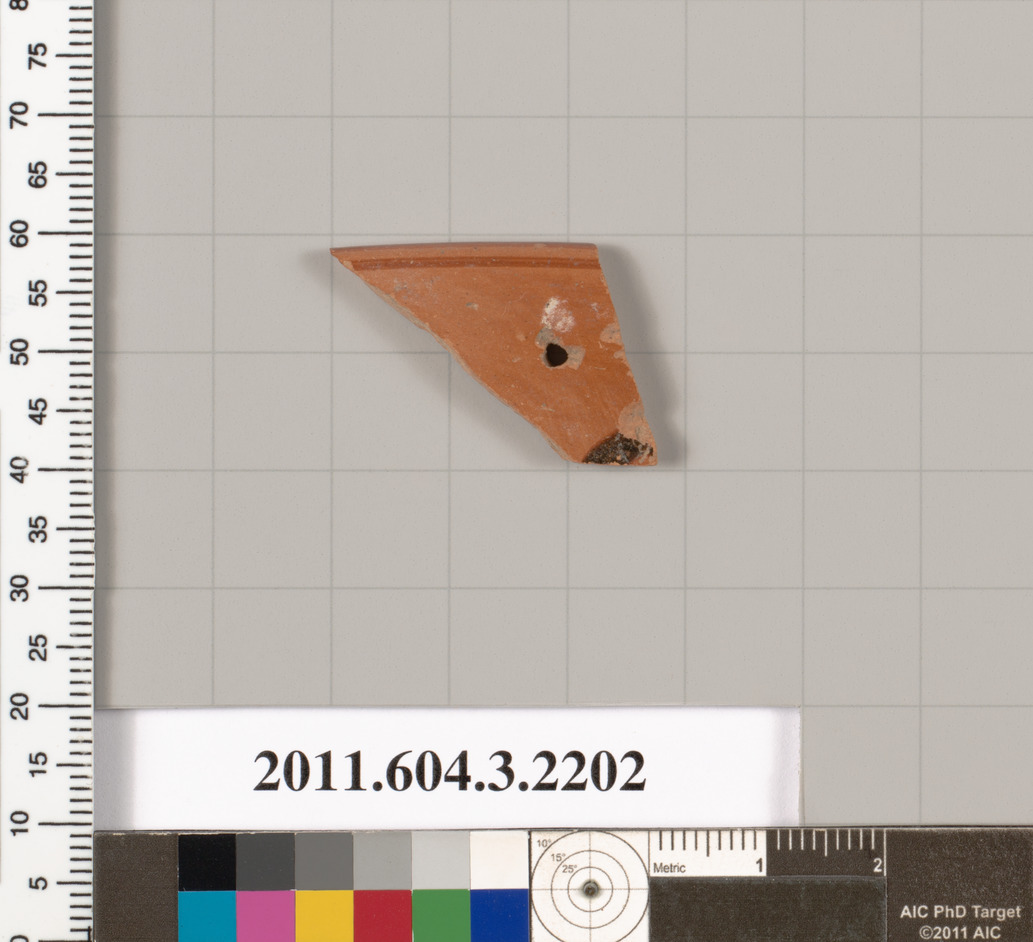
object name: kylix fragment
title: Terracotta rim fragment of a kylix (drinking cup)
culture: greek, attic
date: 600-401 BCE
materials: terracotta